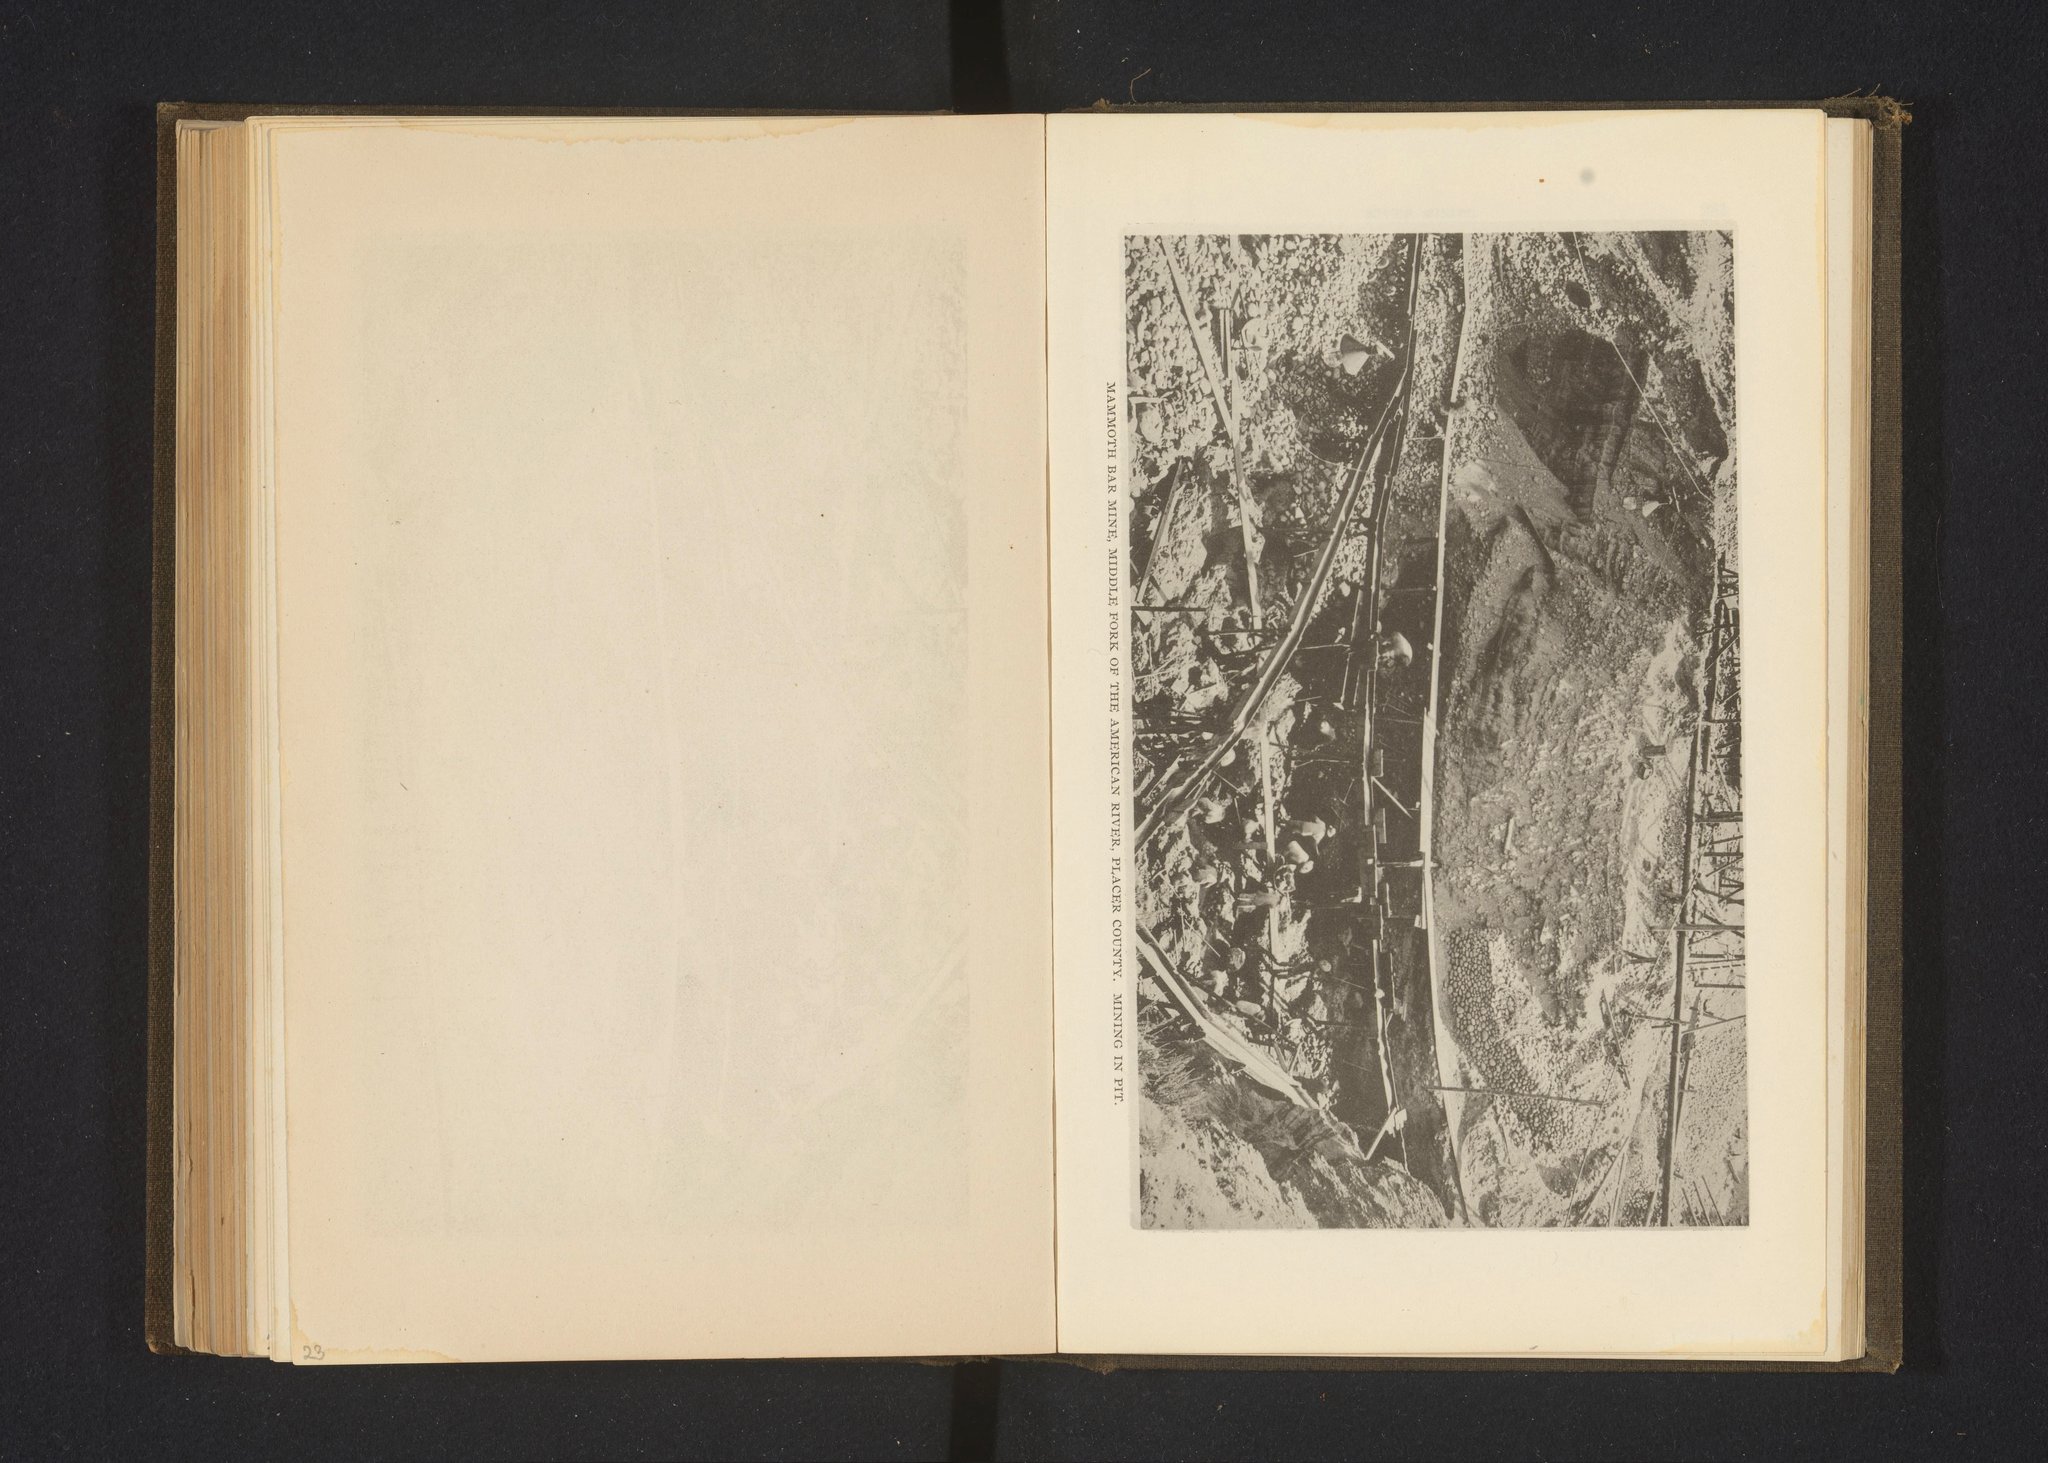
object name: photomechanical print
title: Mammoth Bar Mine, Middle Fork of American River, Placer County. Mining in Pit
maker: Anonymous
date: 1885-1890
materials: paper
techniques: photograph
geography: placer county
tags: miner, mine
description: Prent op tweede ongenummerde pagina na pagina 280.